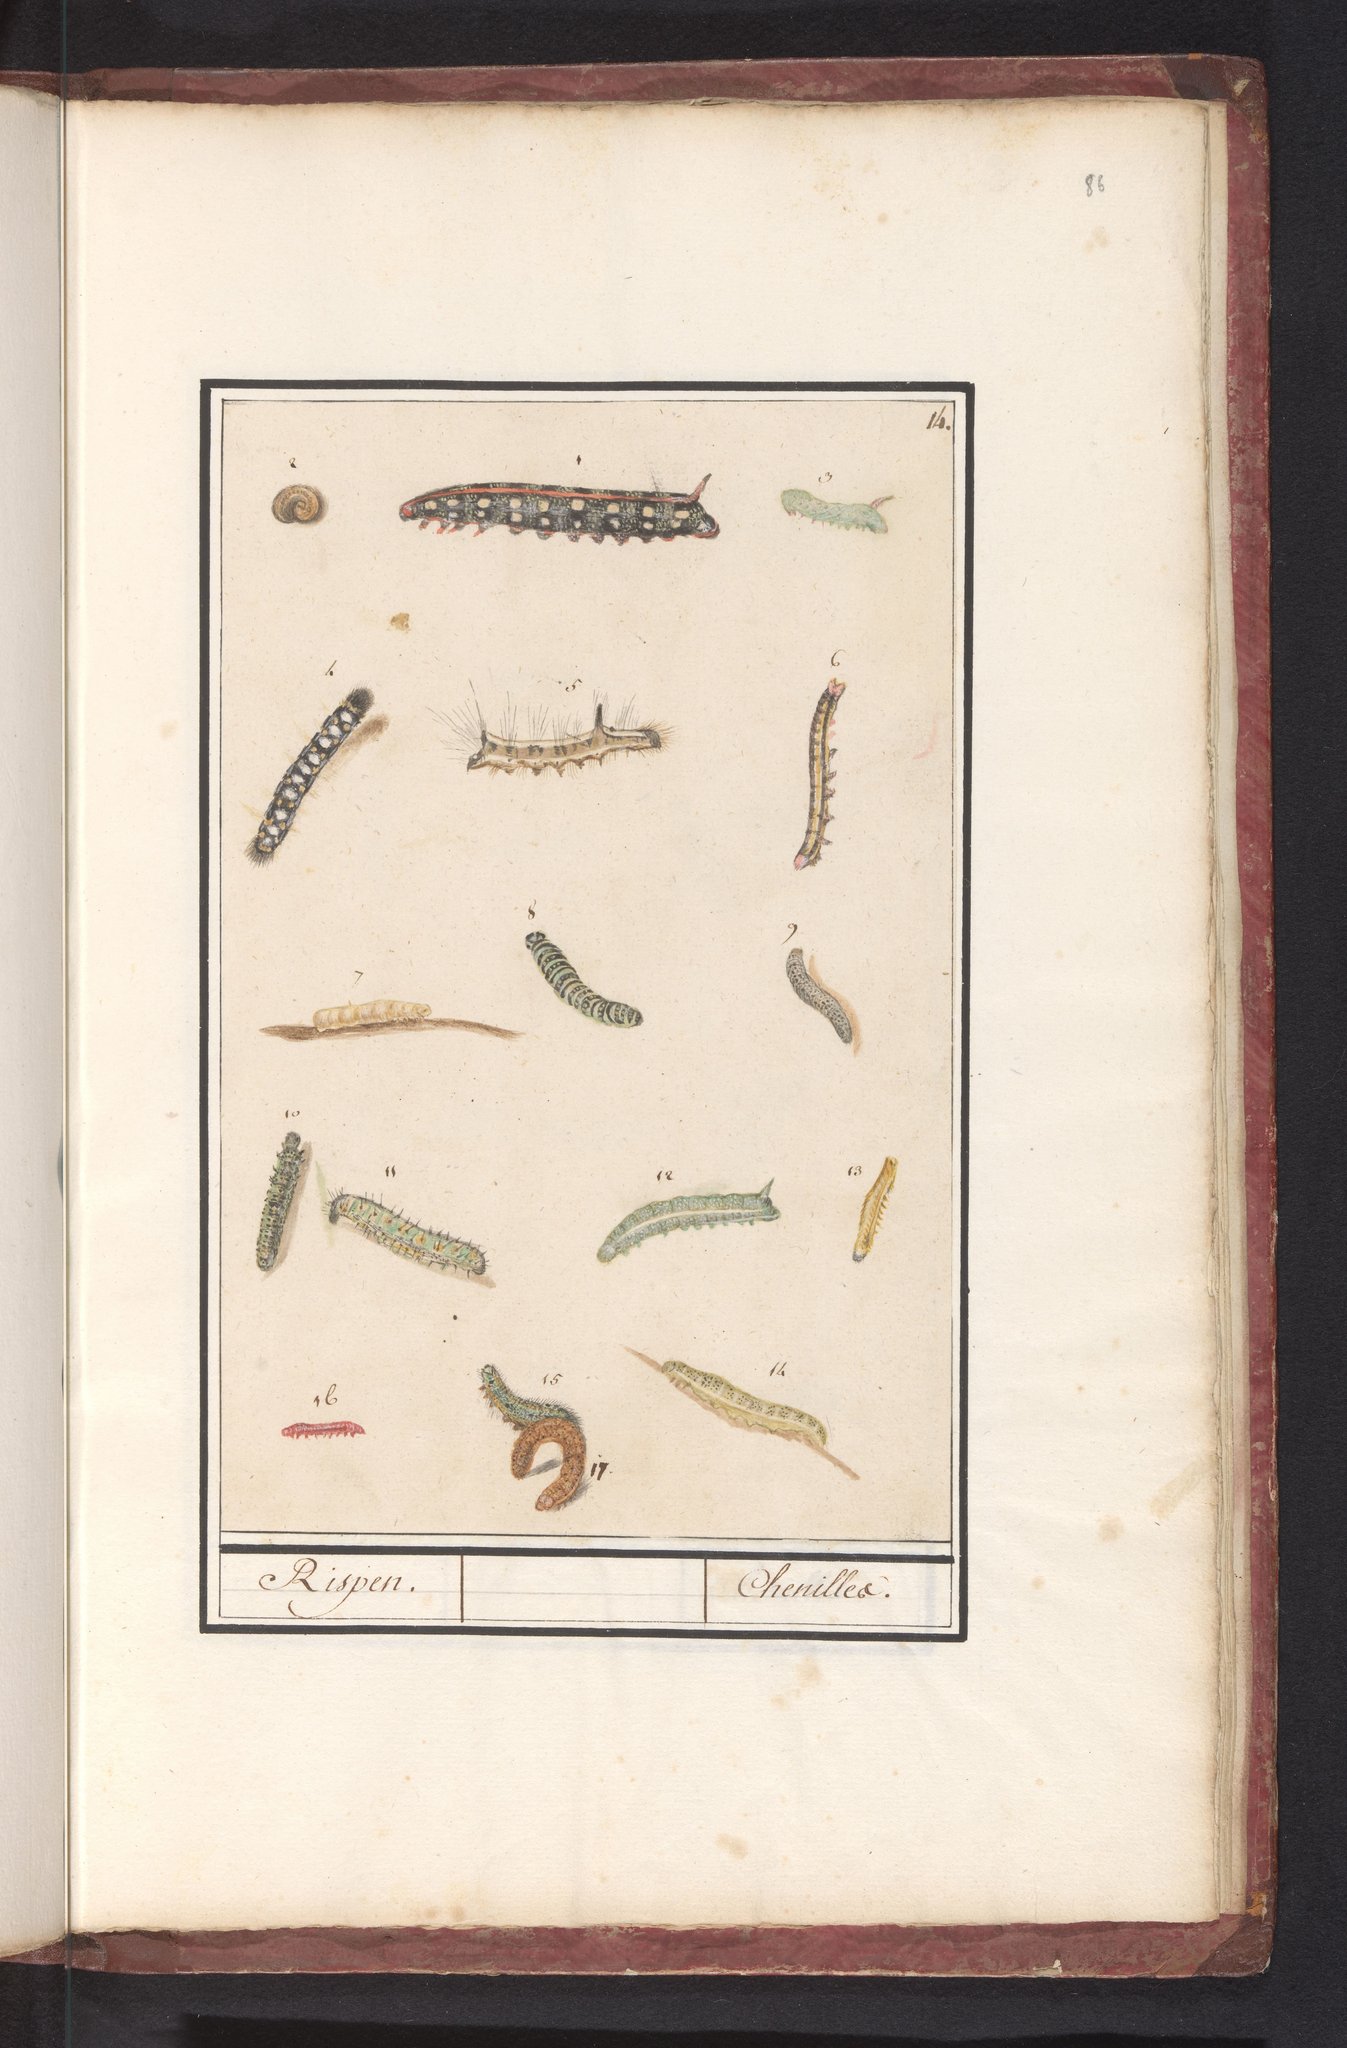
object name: drawing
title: Rispen / Chenilles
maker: anselmus boëtius de boodt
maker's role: draughtsman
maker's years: 1550-1632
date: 1596-1610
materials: chalk, paint, ink, paper, pencil, watercolor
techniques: brush, pen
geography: prague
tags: insects: caterpillar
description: Blad met zeventien verschillende rupsen, genummerd 1-17. Genummerd rechtsboven: 14. Onderdeel van het zesde album met tekeningen van vissen, schelpen en insekten. Zesde van twaalf albums met tekeningen van dieren, vogels en planten bekend rond 1600, gemaakt in opdracht van keizer Rudolf II. Met toelichting in Nederlands, Latijn en Frans.